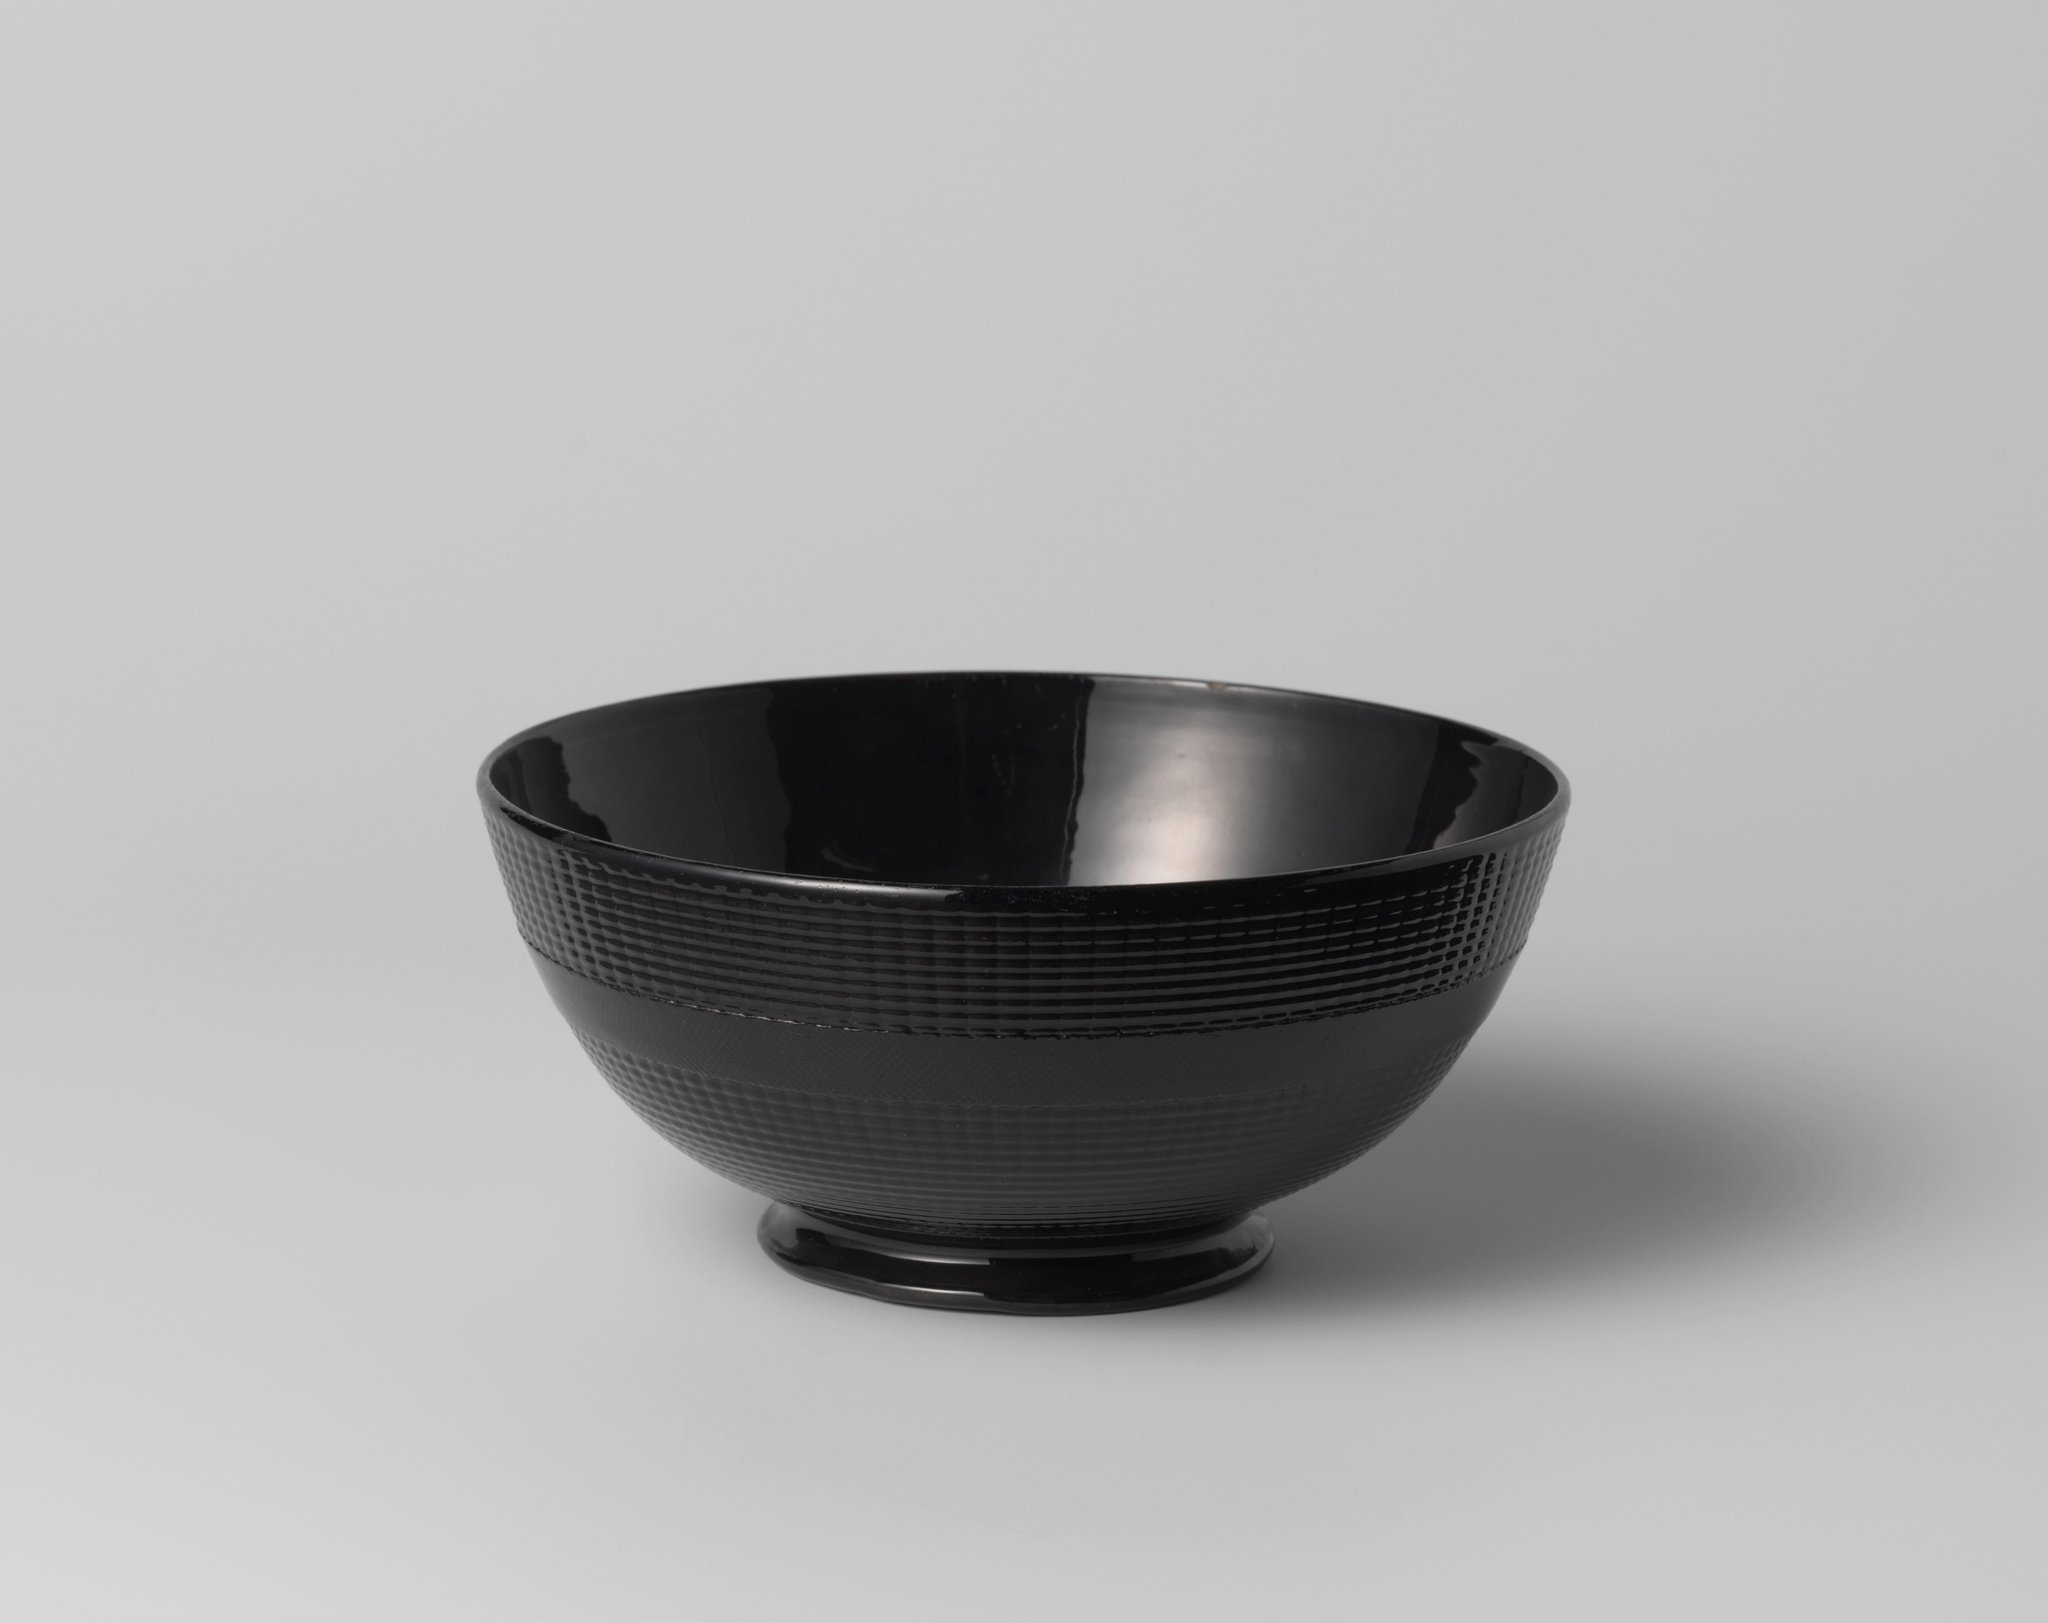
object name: bowl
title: Kom, zwart, gedecoreerd met ribbelranden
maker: petrus regout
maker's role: plateelbakker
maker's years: 1801-1879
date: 1860-1880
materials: stoneware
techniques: engels steengoed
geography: maastricht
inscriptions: inscription: ‘46’, check stamp: ‘PR. // 2’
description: Kom van zwartsteen, gedecoreerd met ribbelranden. Het lichaam met dicht op elkaar gelegen ribbelranden.